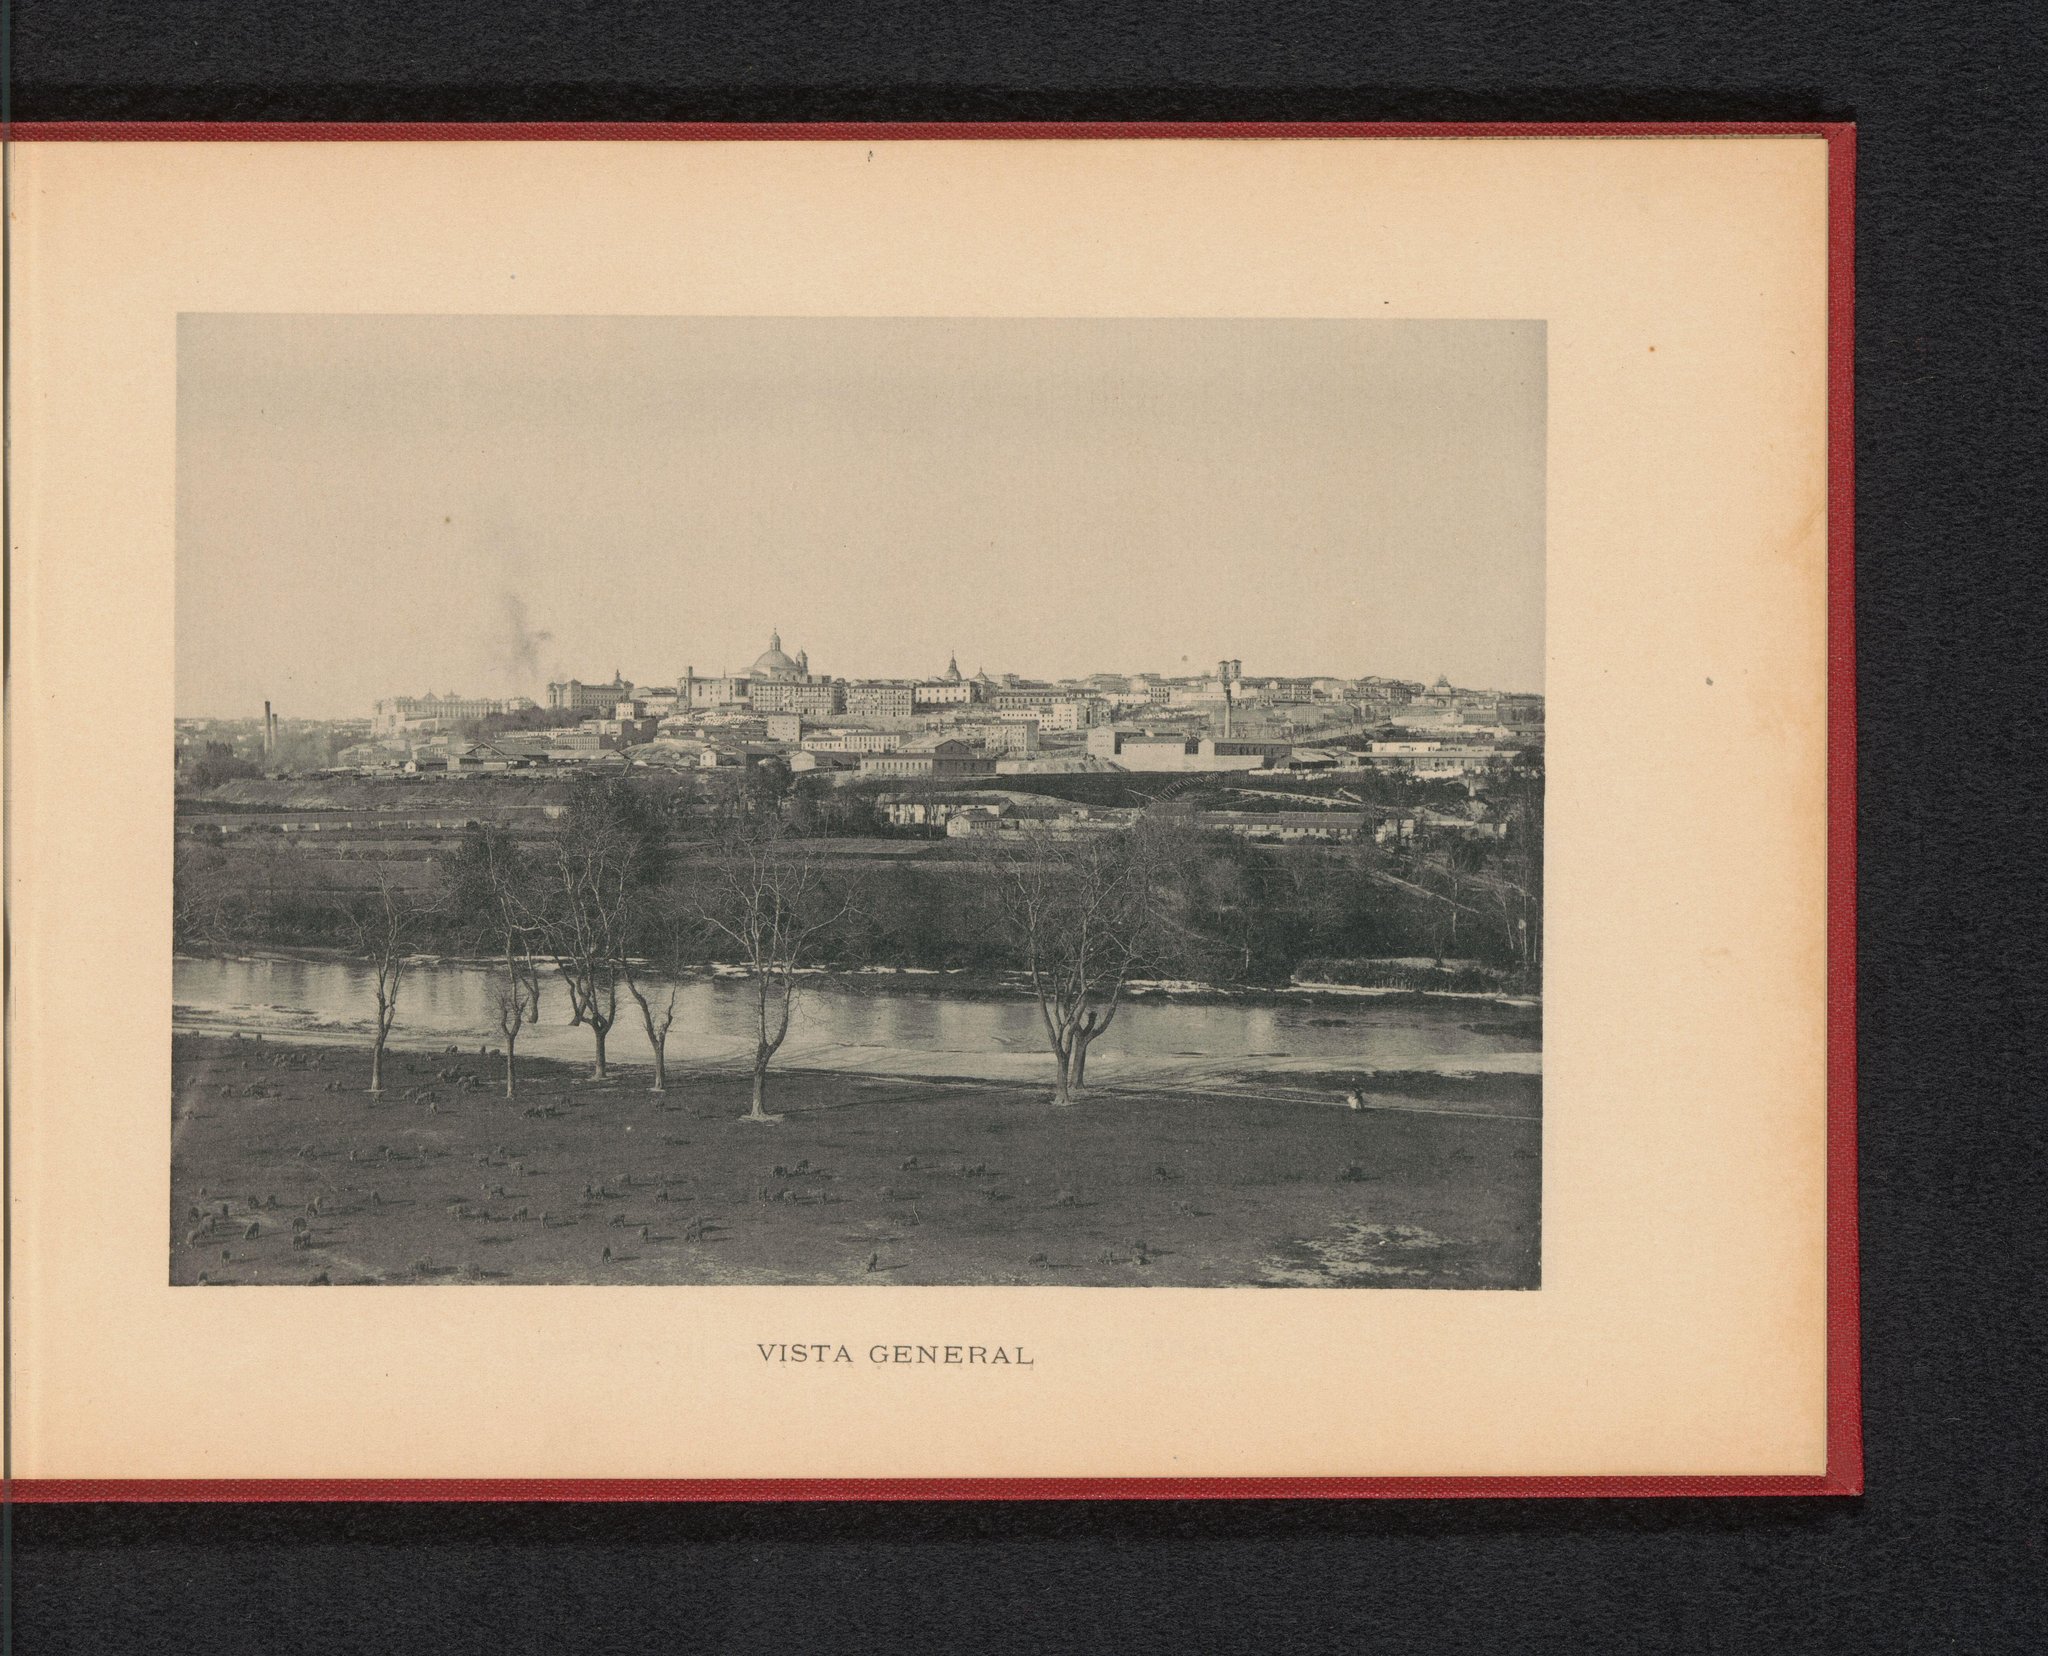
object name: page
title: Gezicht op Madrid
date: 1888-1898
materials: paper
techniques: photograph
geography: madrid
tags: city-view in general; 'veduta'